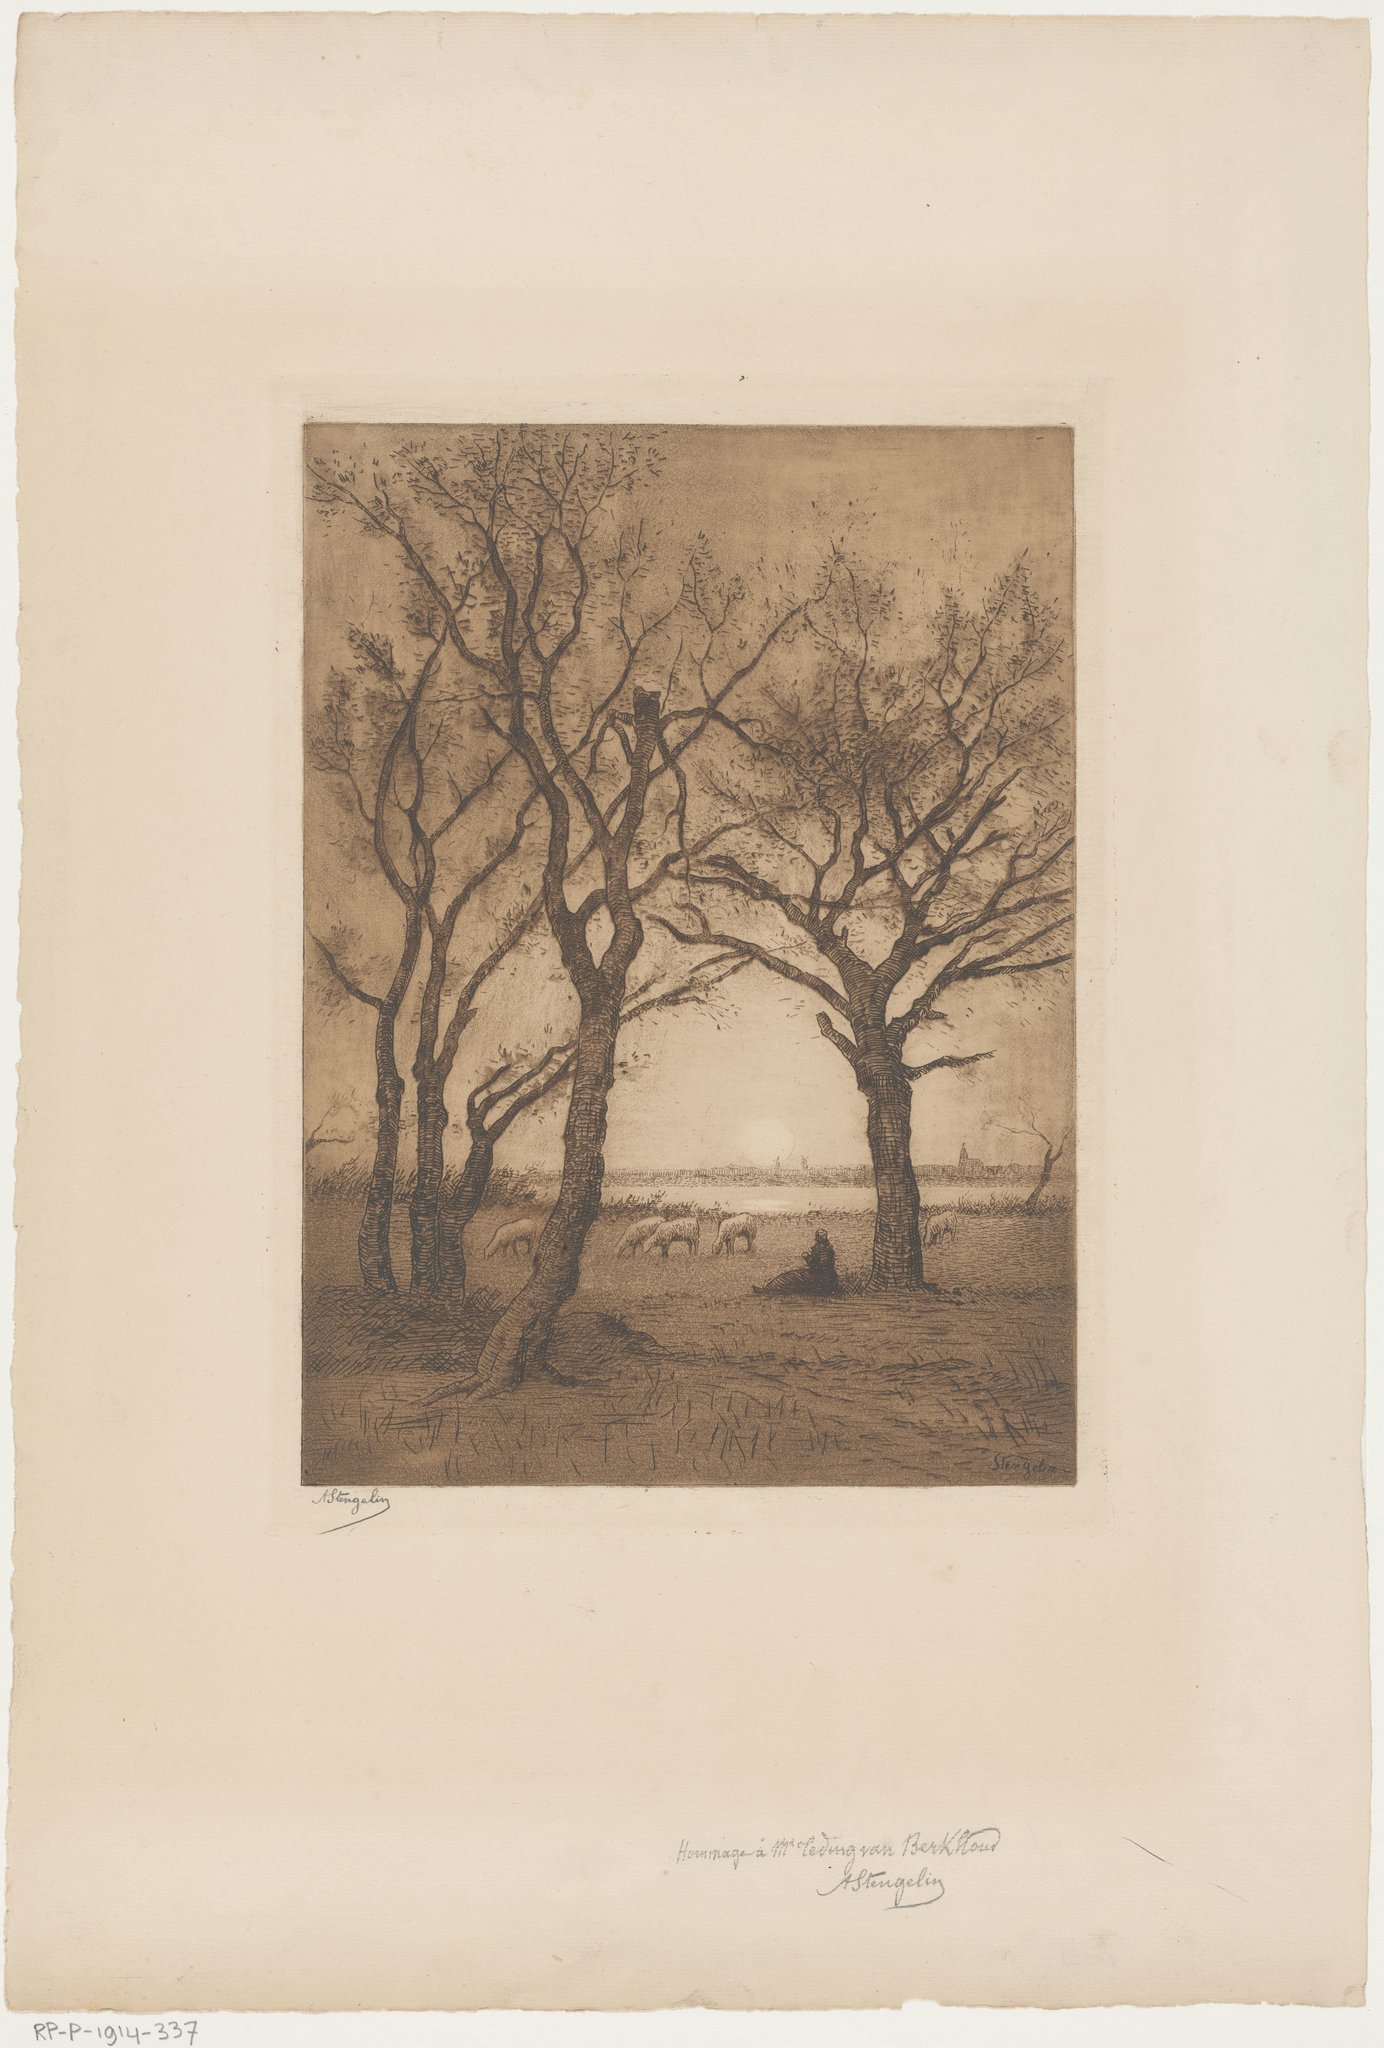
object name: print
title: Landschap met schapen bij zonsondergang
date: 1903-1914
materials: paper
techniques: aquatint, etching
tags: sheep, sunset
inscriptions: collector's mark: Lugt 2233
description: Landschap in Drenthe met schapen en vrouw zittend bij boom.